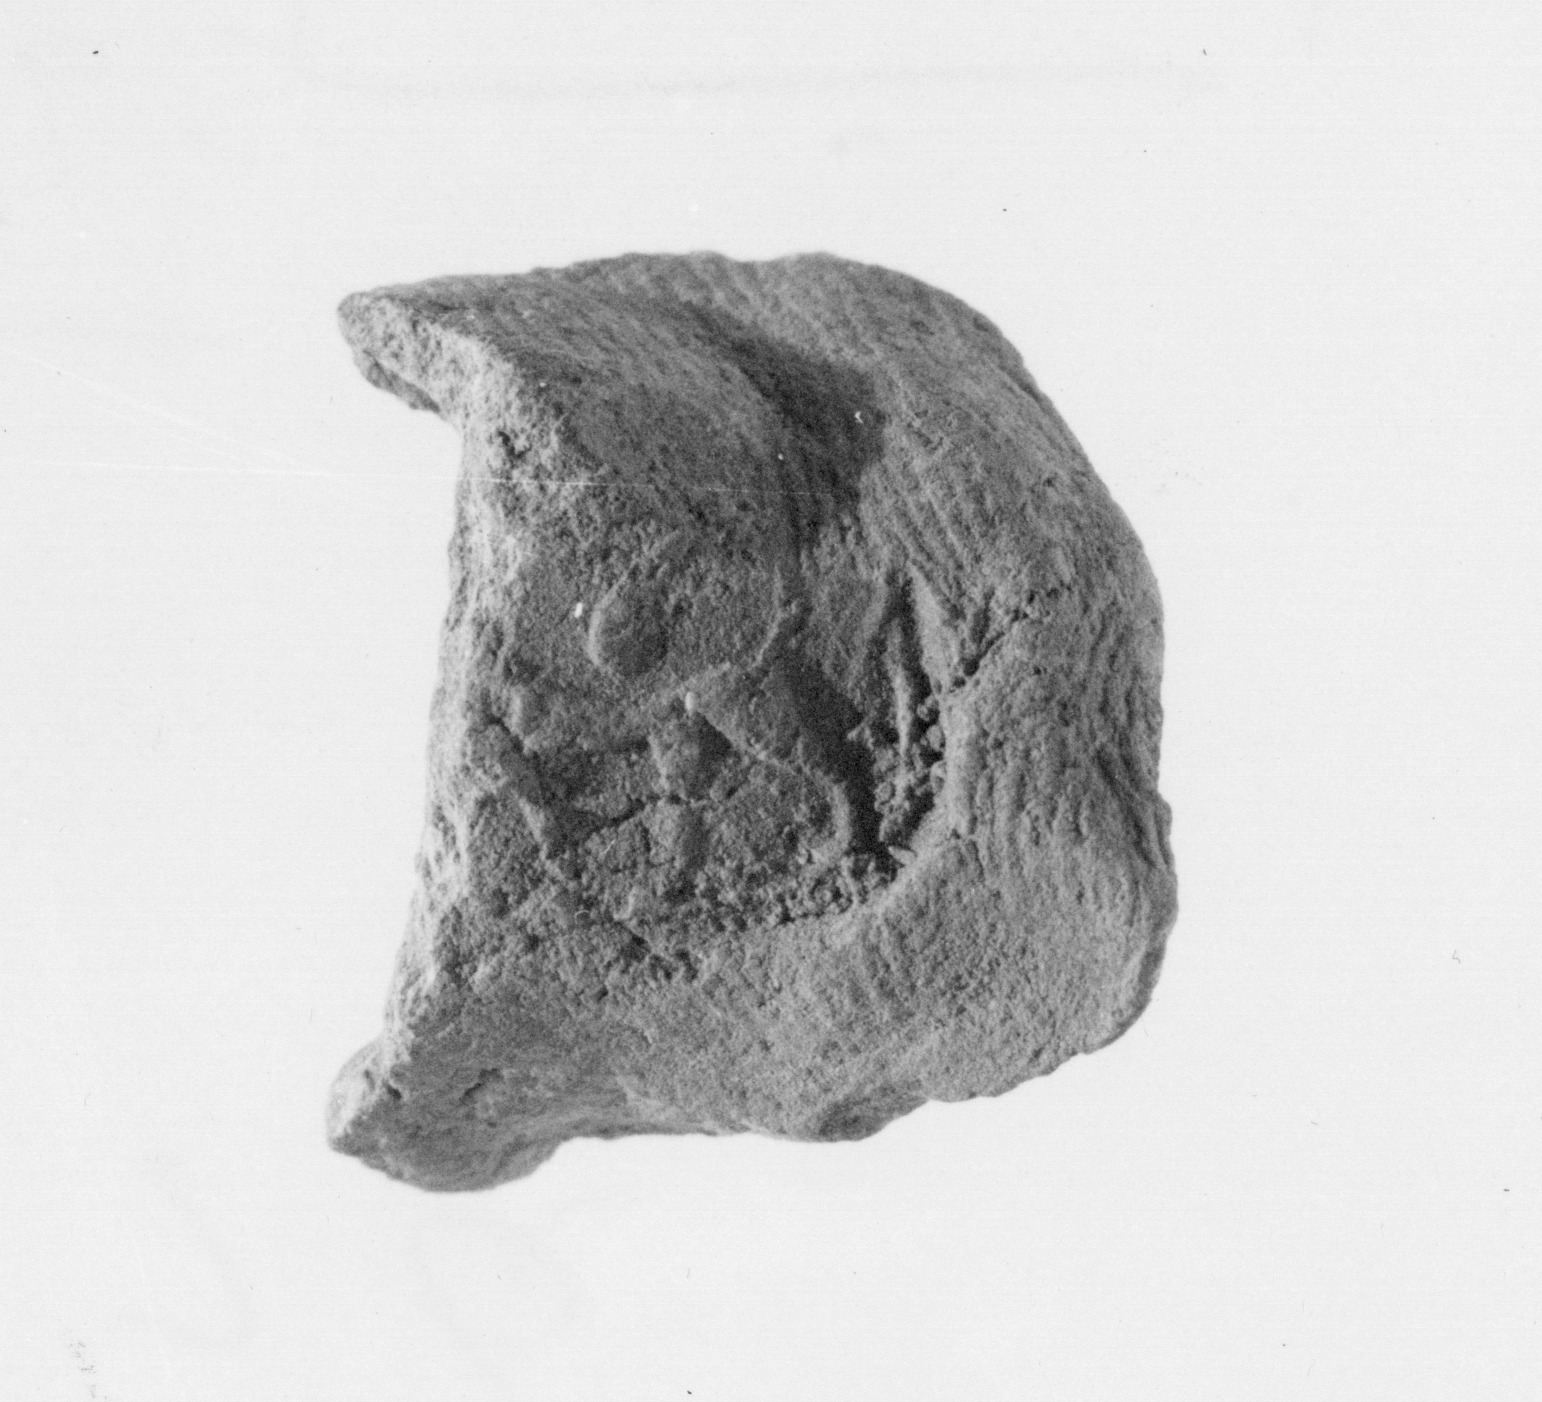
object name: sealing, walking lion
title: Document Sealing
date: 1390-1352 BCE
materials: mud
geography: egypt